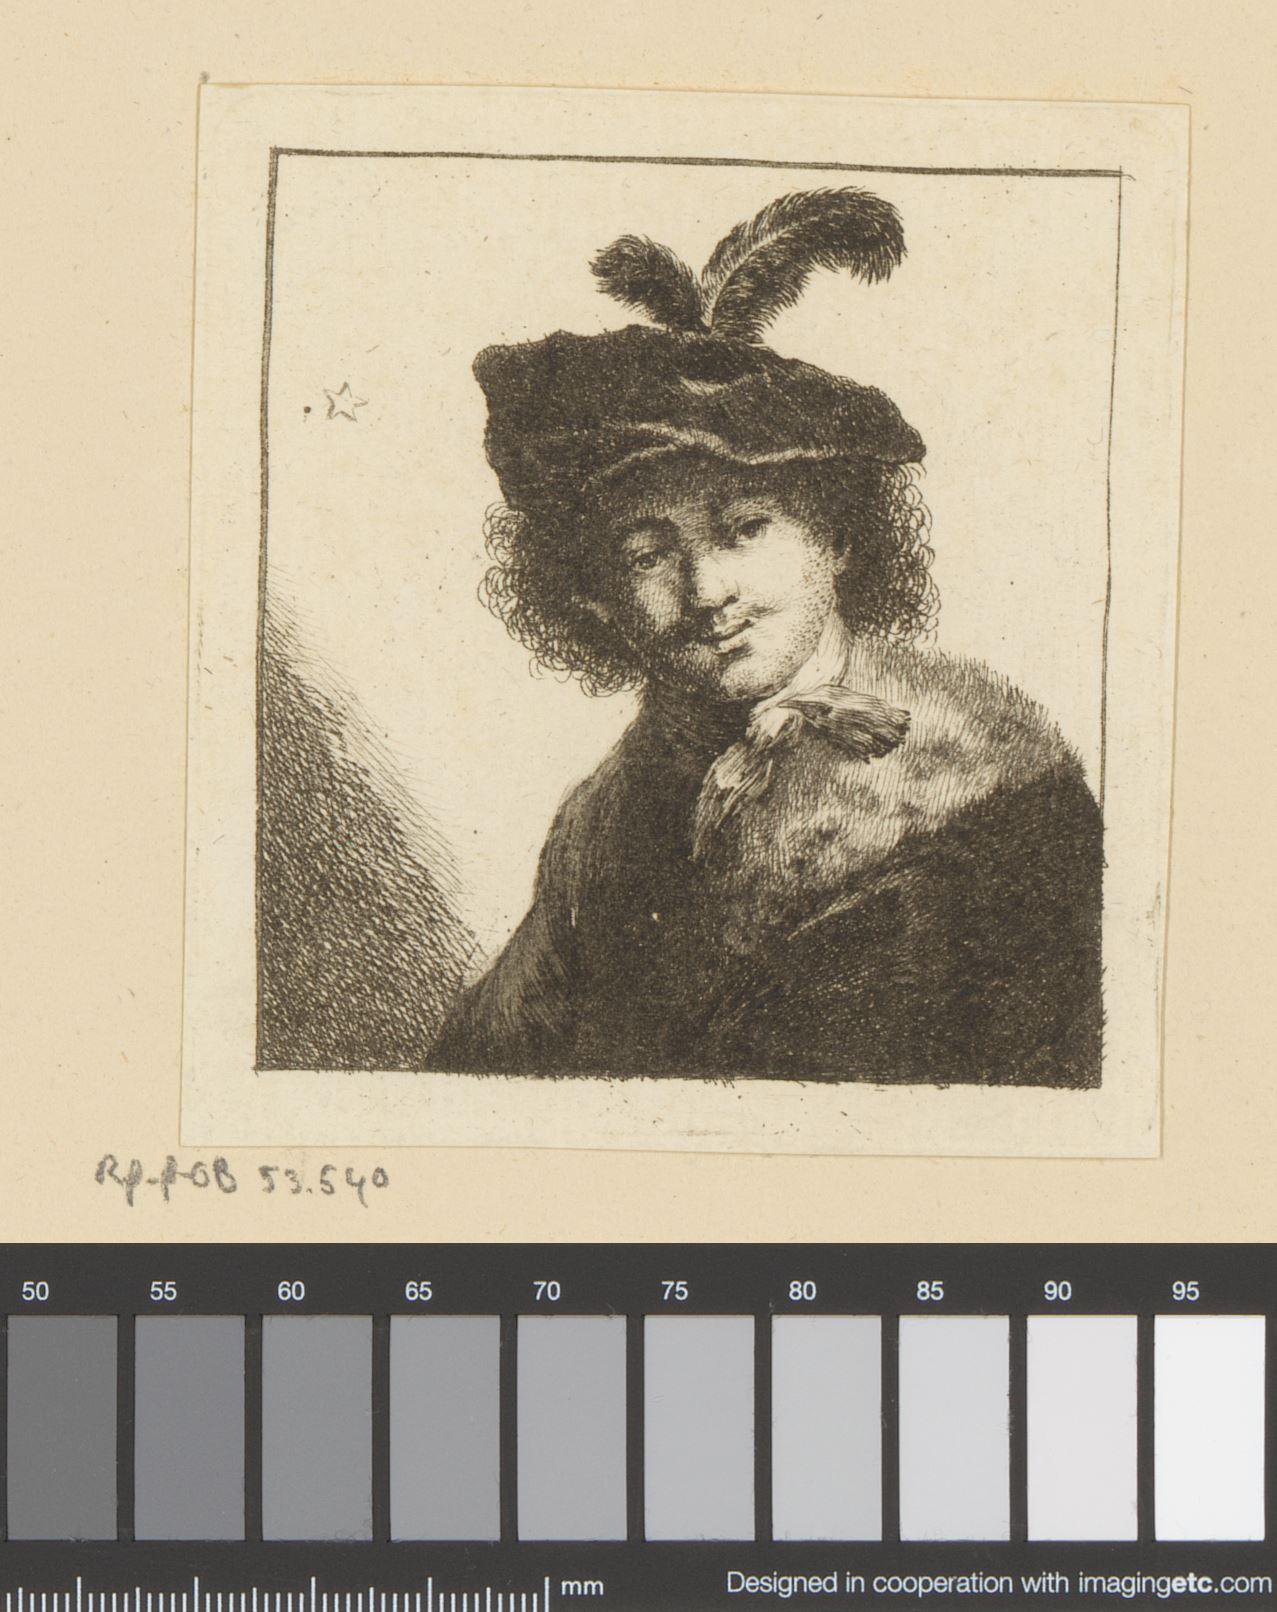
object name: print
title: Man met baret met veer en bontkraag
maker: johann andreas benjamin nothnagel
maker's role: print maker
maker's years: 1729-1804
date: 1739-1804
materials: paper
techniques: etching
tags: adult man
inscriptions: collector's mark: Lugt 240